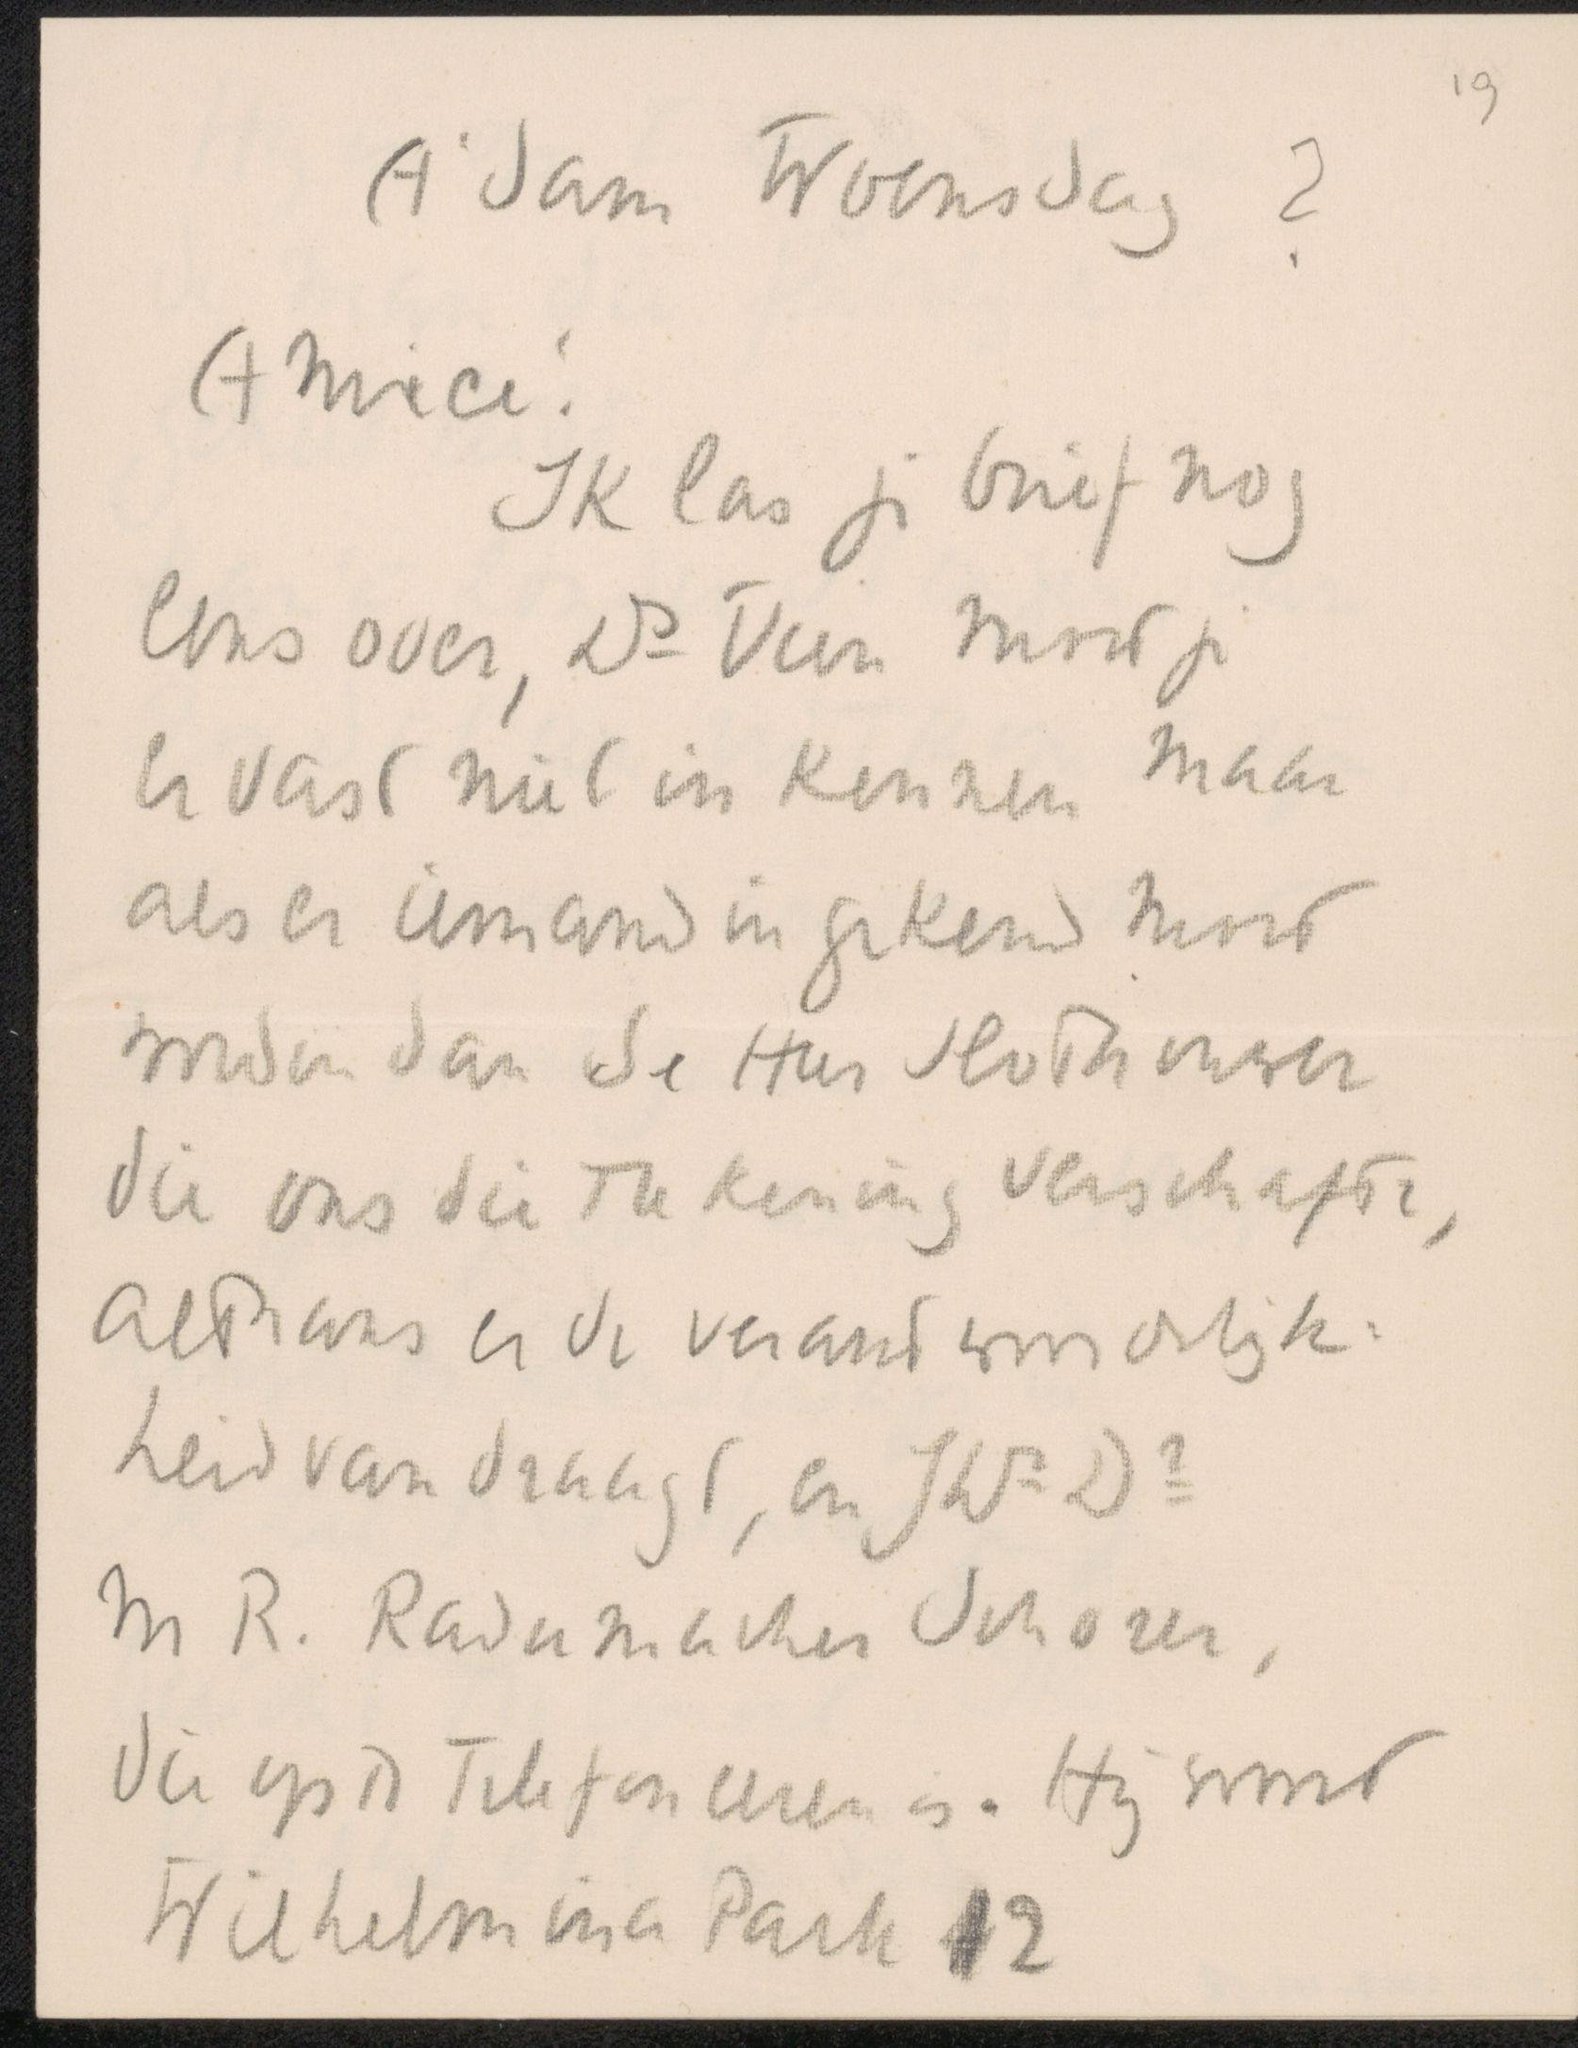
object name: letter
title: Brief aan Willem Bogtman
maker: richard nicolaüs roland holst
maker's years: 1868-1938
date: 1923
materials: ink, paper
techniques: pen, writing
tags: utrecht, indonesia, the hague, haarlem, willem bogtman